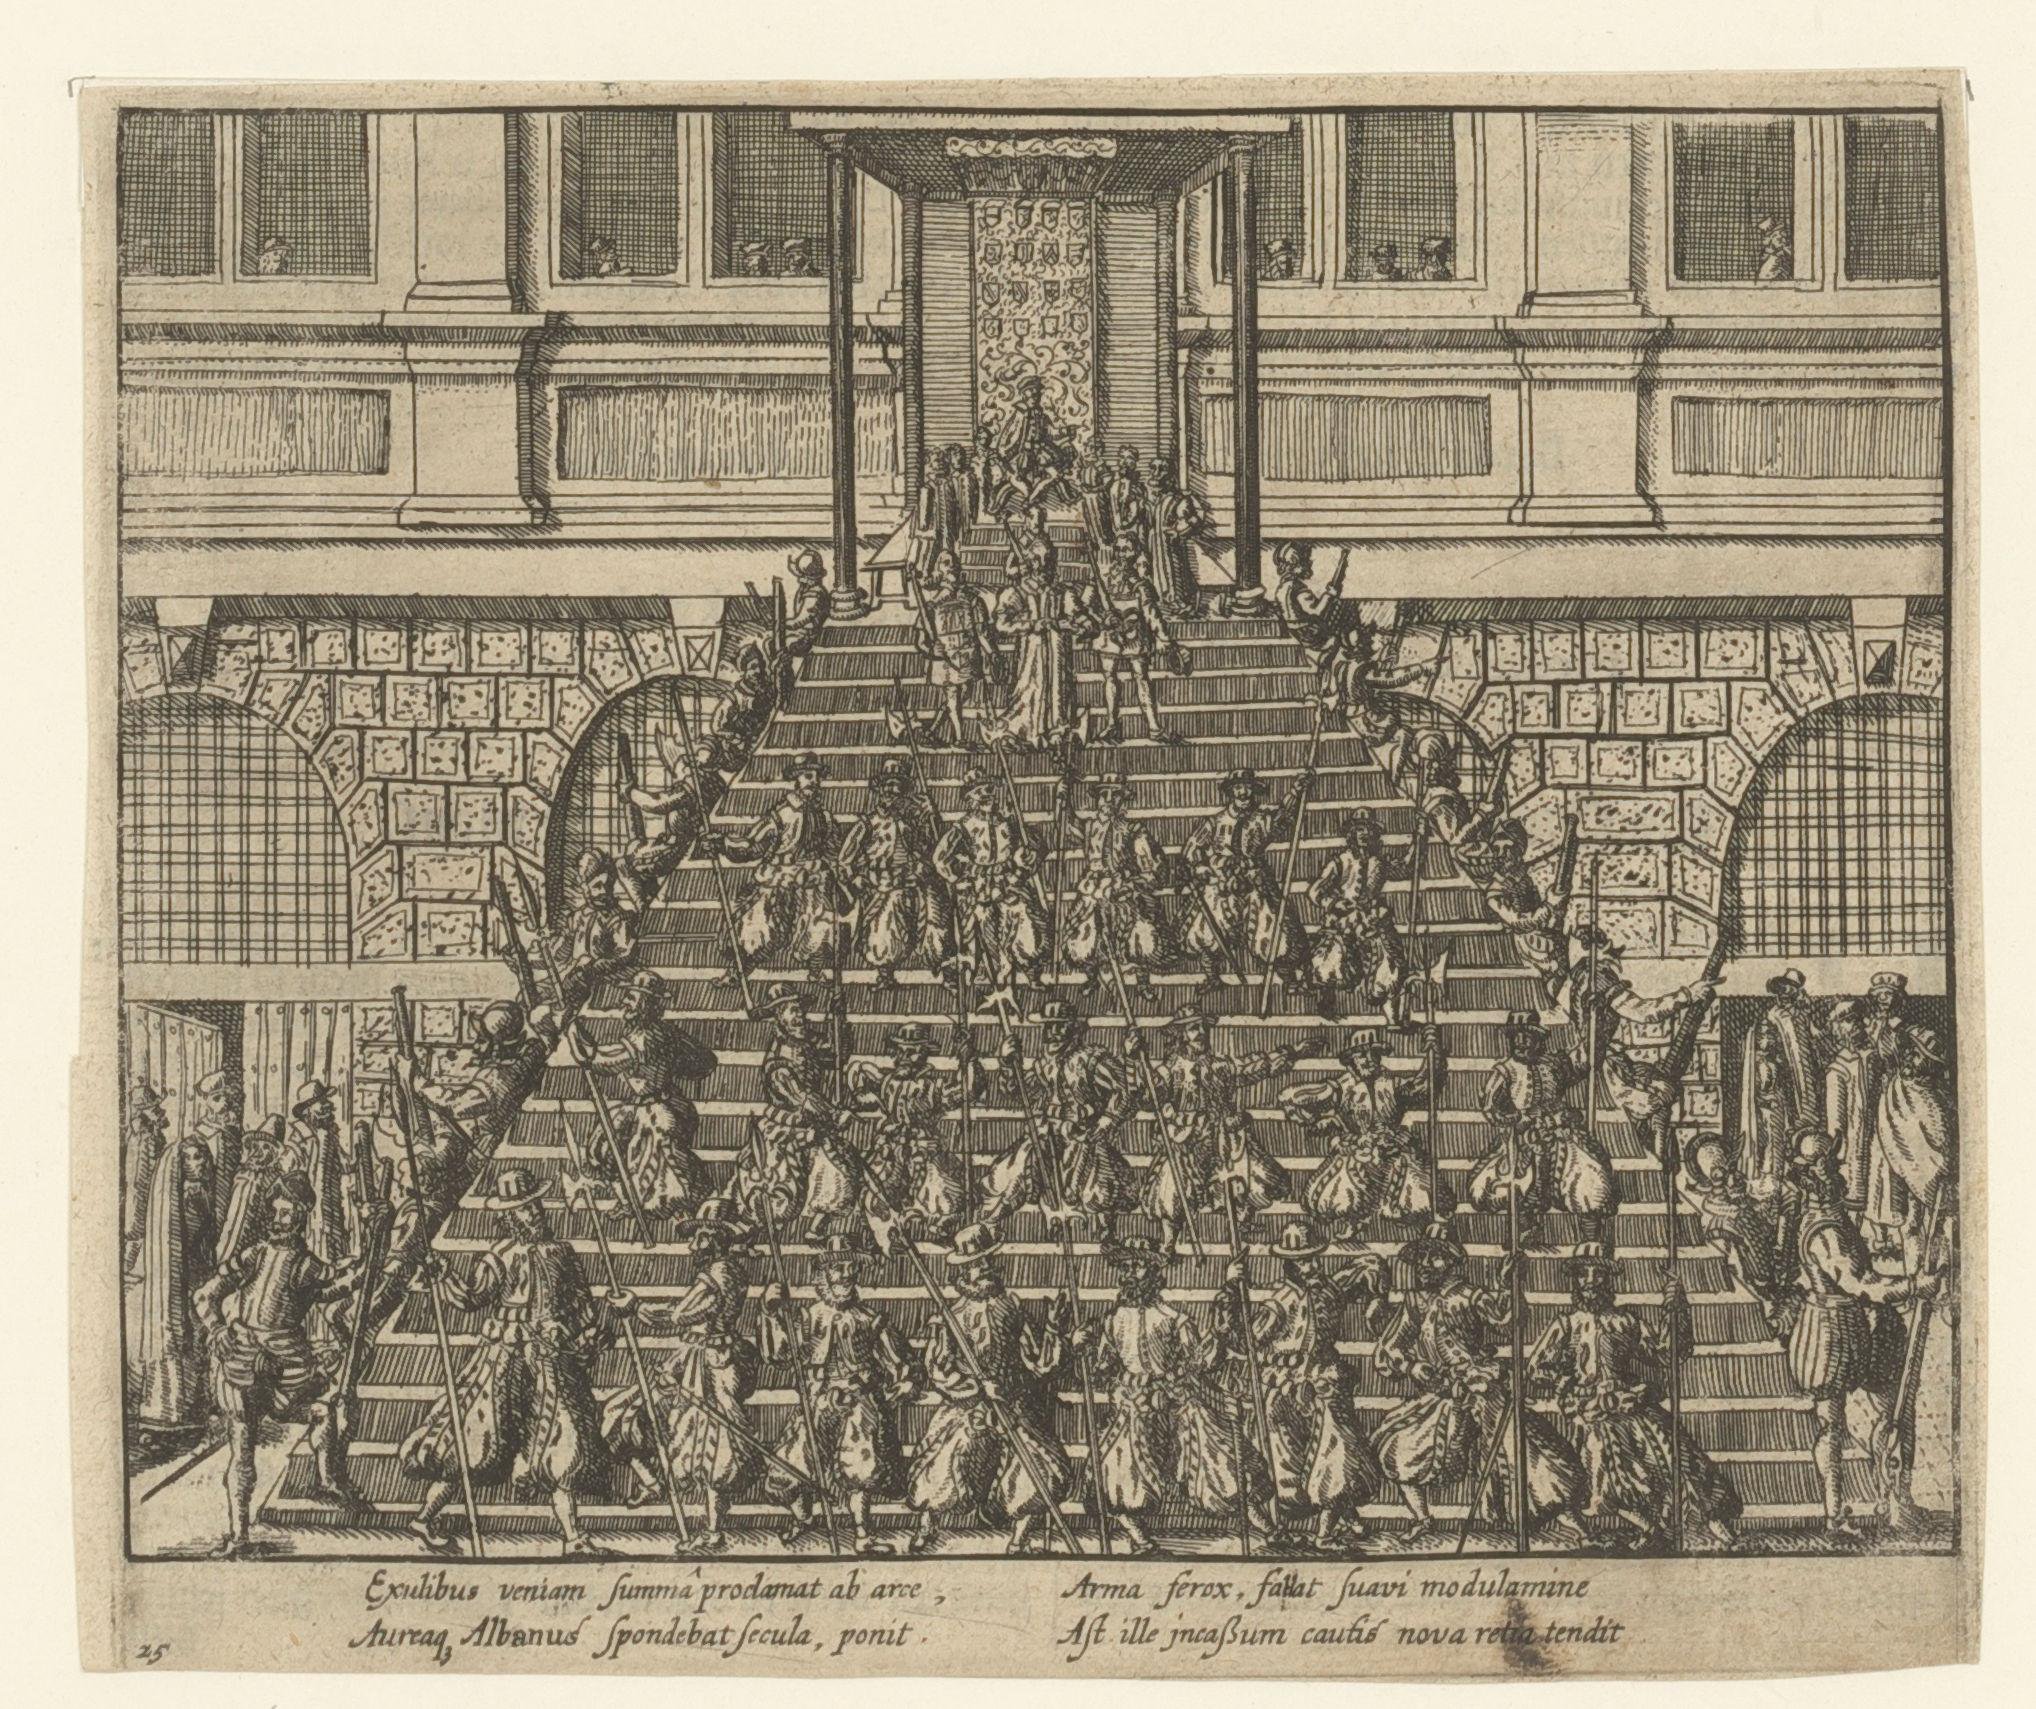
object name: book illustration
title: Afkondiging van het Generaal Pardon, 1570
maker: Anonymous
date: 1613-1615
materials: paper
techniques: etching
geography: northern netherlands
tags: fernando álvarez de toledo (3rd duke of alba), granting mercy; free pardon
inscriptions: collector's mark, collector's mark: Lugt 1641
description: Afkondiging van het Generaal Pardon, 16 juli 1570. Op een stellage voor het stadhuis van Antwerpen laat Alva het Algemeen Pardon voorlezen. Bovenaan zit Alva op een troon, op de trappen daaronder zitten soldaten. Met onderschrift van 4 regels in het Latijn. Genummerd: 25. Bedrukt op achterzijde met tekst in het Nederlands. Onderwerpsrubrieken binnen de Atlas Zeden en Gewoonten: Krijgswezen; prenten van Baudart. 80j. oorlog.